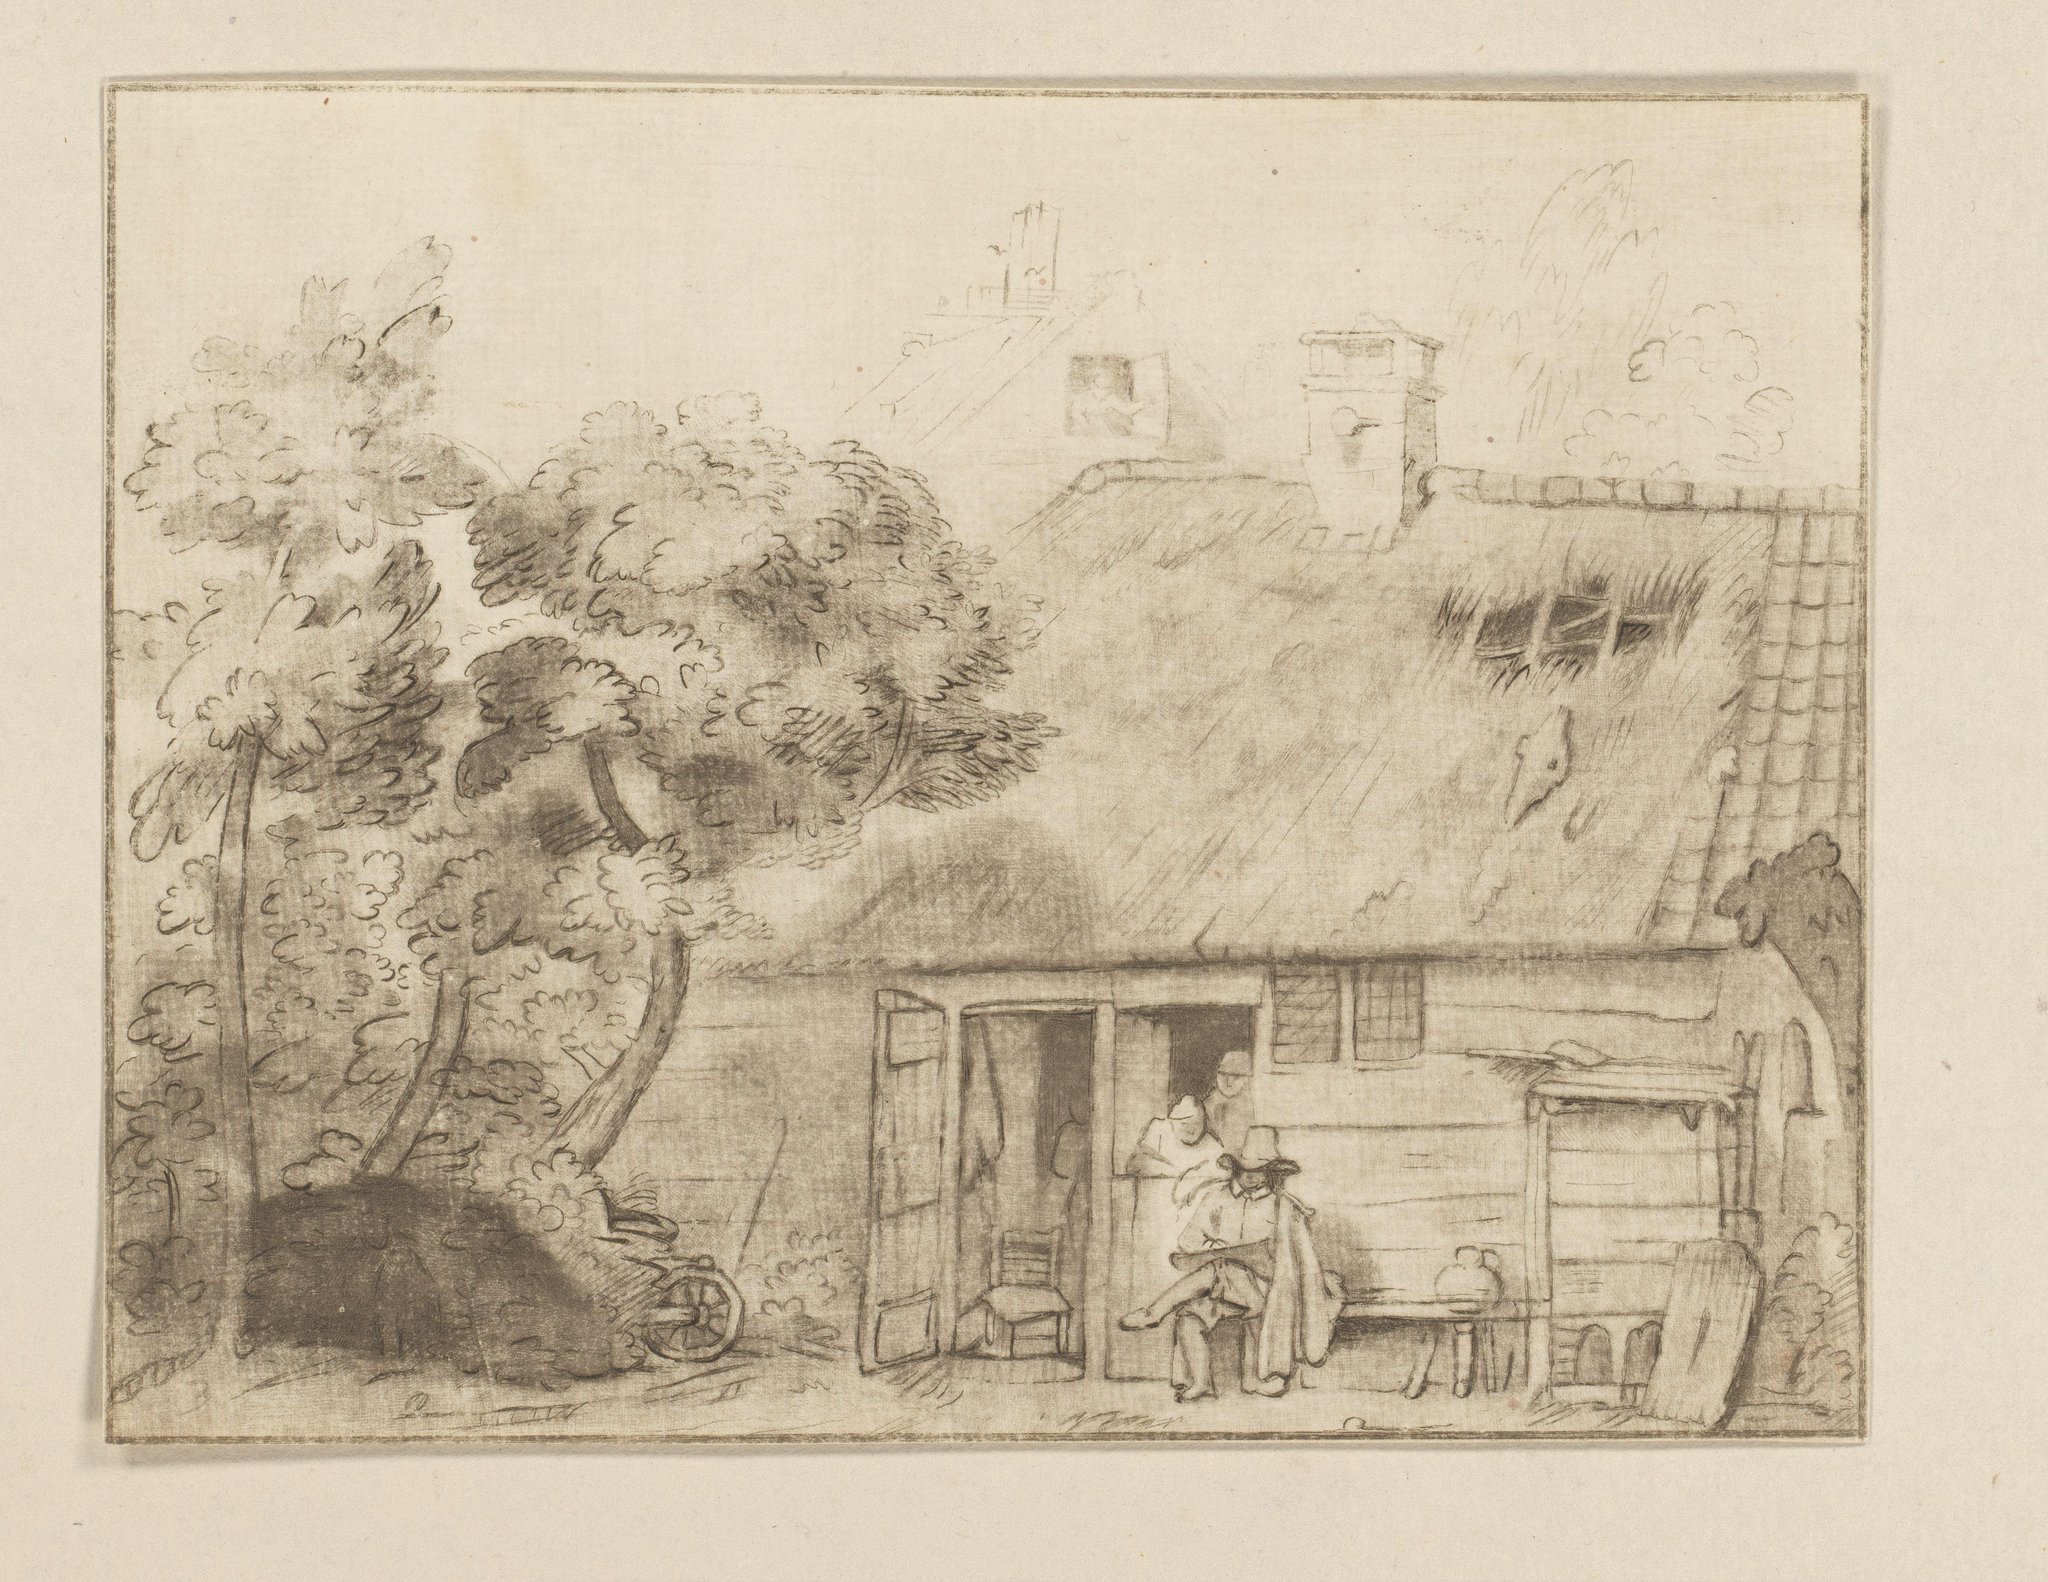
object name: print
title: Tekenaar voor boerderij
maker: cornelis ploos van amstel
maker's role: draughtsman, print maker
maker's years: 1726-1798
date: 1765-1769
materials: paper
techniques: etching, roulette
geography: amsterdam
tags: draughtsman at work, farm (building)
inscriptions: collector's mark: ‘RIJKS / MUSM’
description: Een tekenaar zit op een bank voor een boerderij. Twee mensen leunen op de onderdeur. De prent ligt los in een album, zie blad 58.